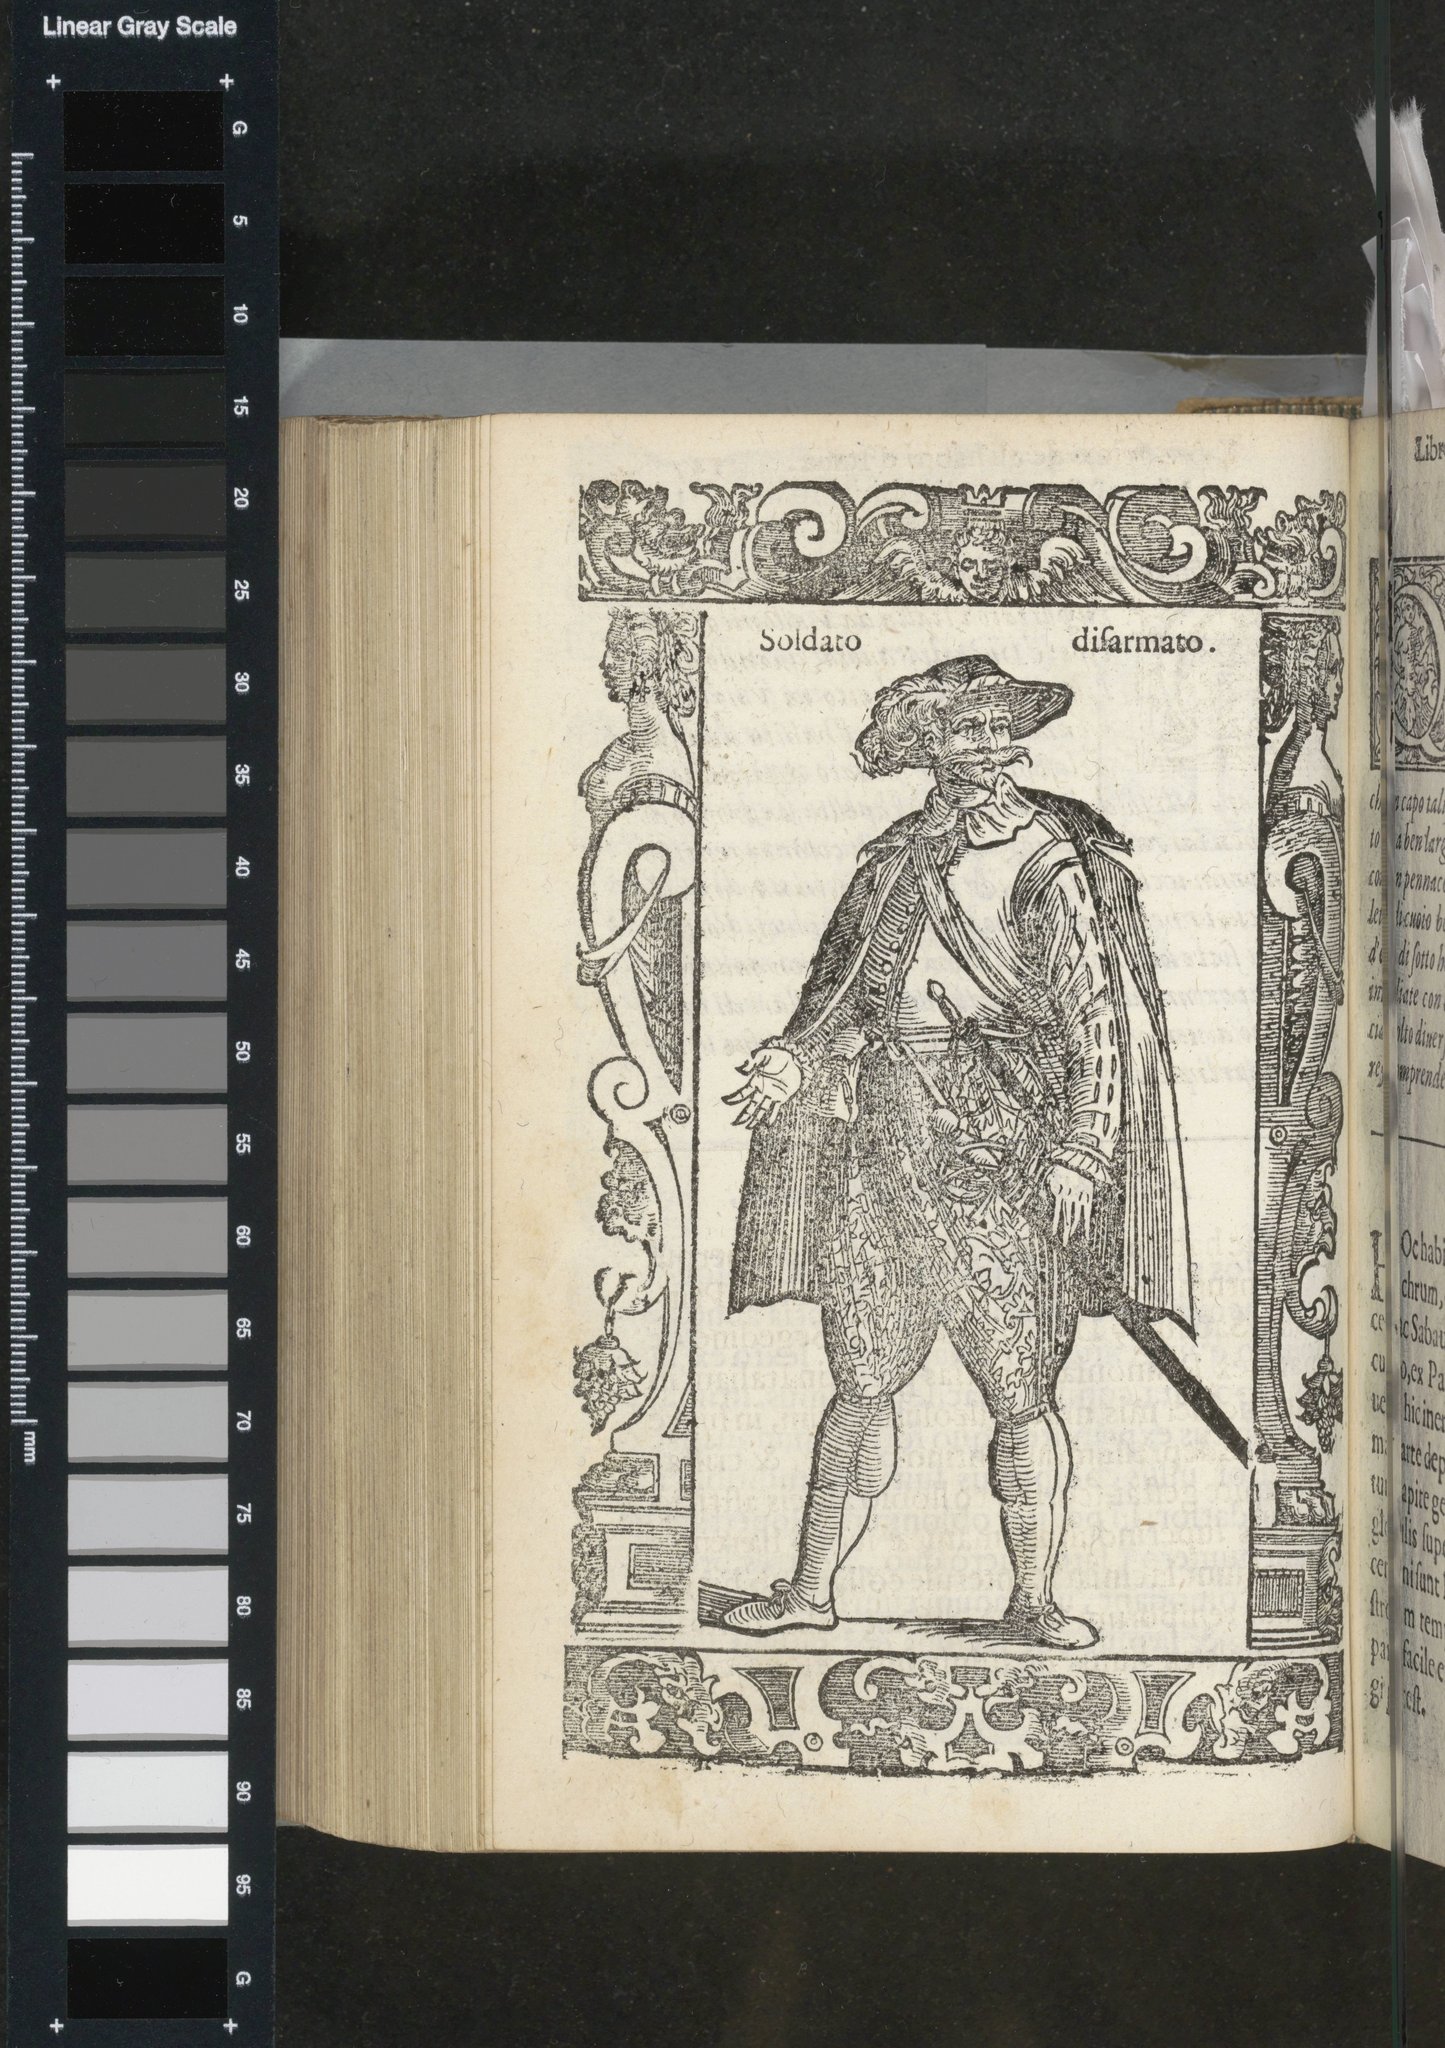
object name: costume print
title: Habiti antichi, et moderni di tutto il mondo...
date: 1598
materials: paper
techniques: woodcut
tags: fashion plates